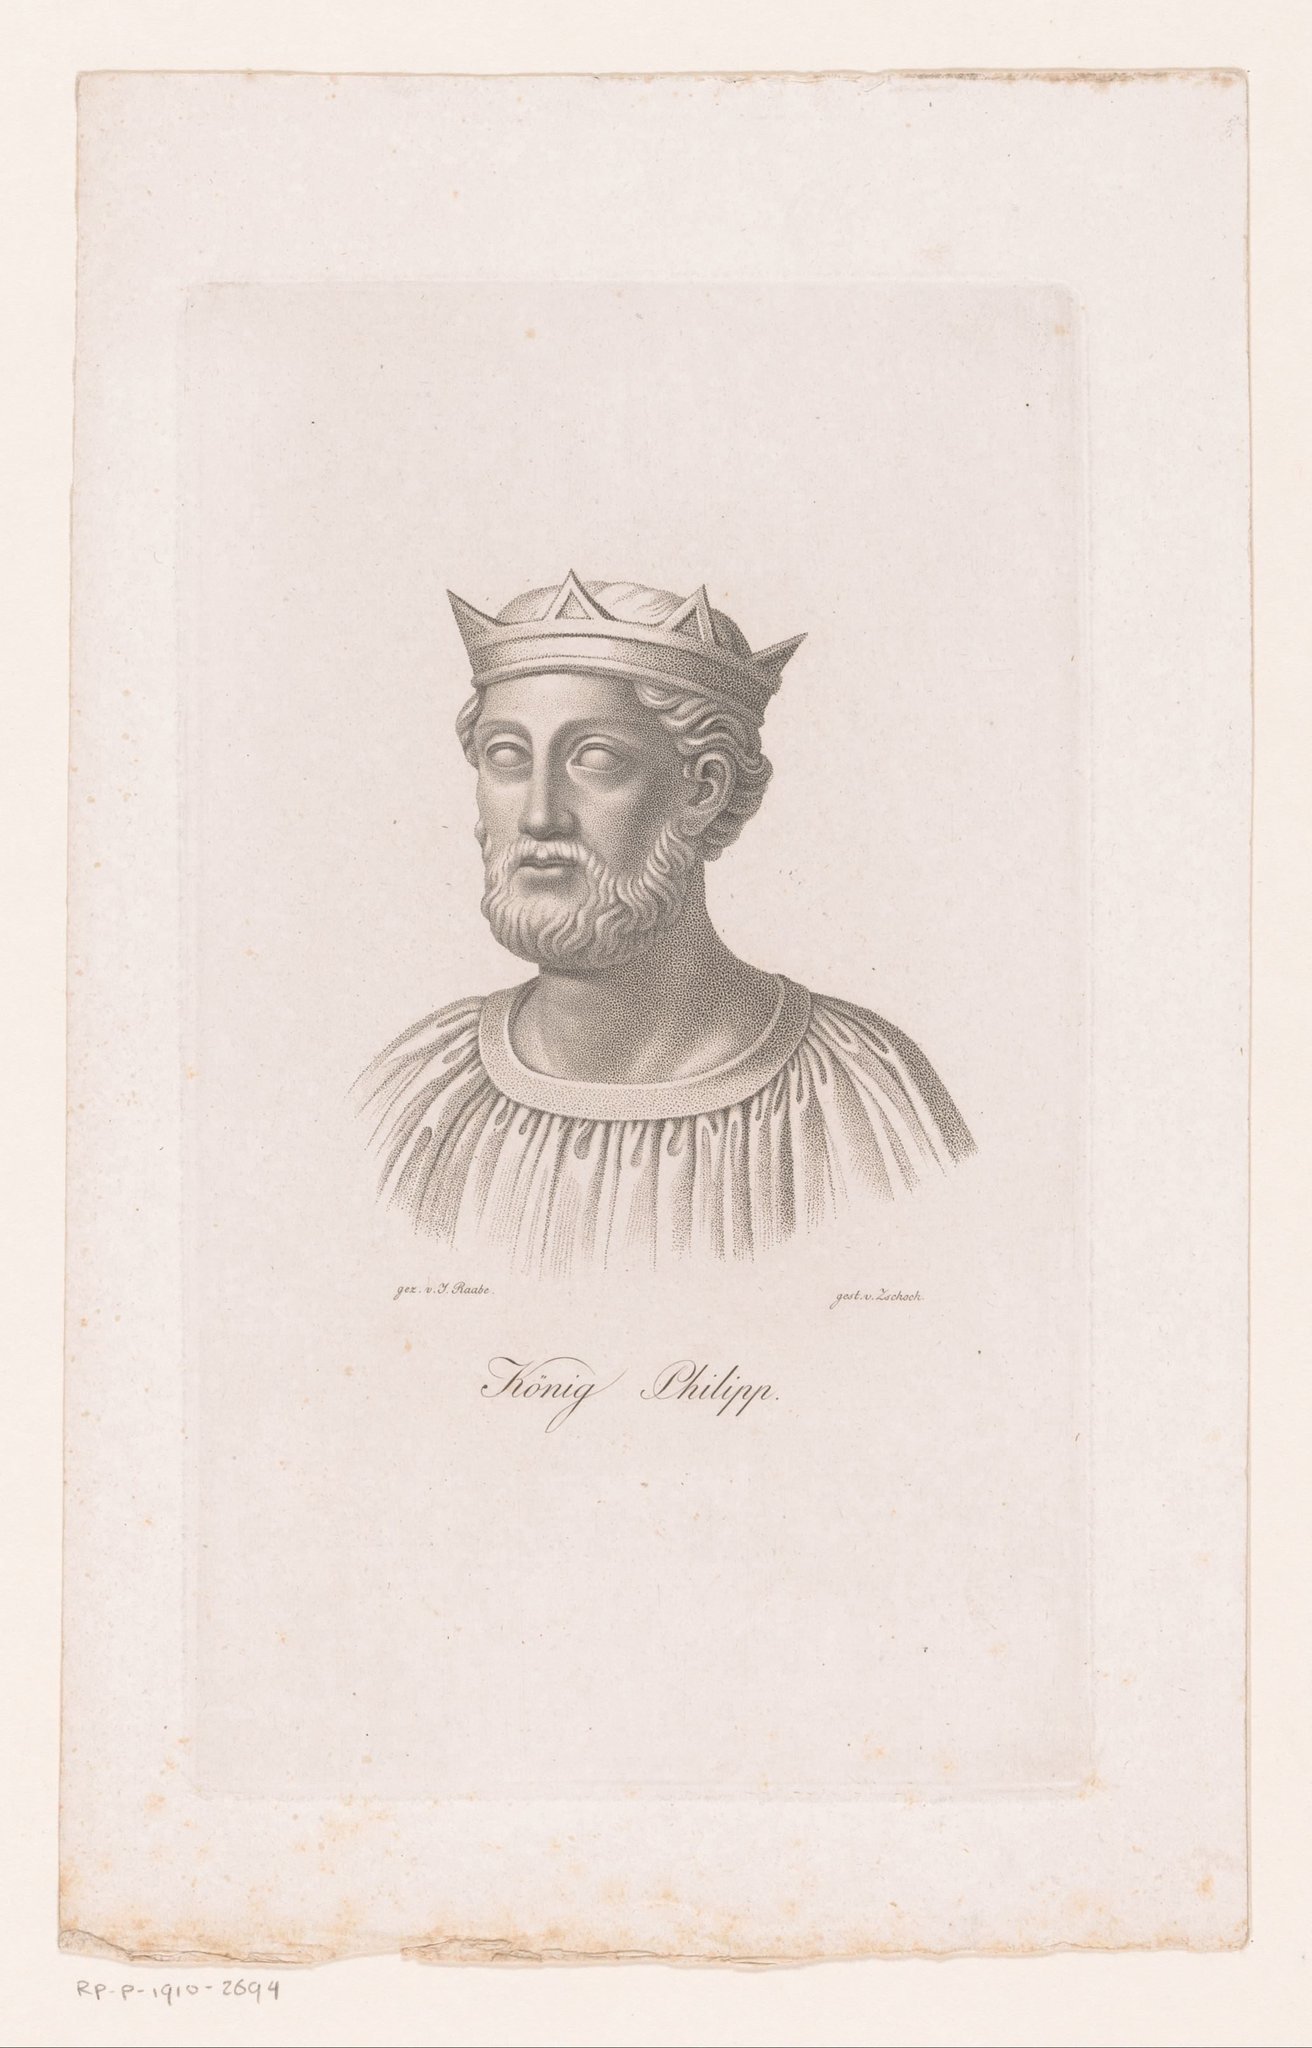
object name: print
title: Portret van koning Filips van Zwaben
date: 1790-1833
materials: paper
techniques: engraving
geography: germany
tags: historical persons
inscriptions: collector's mark: Lugt 2228